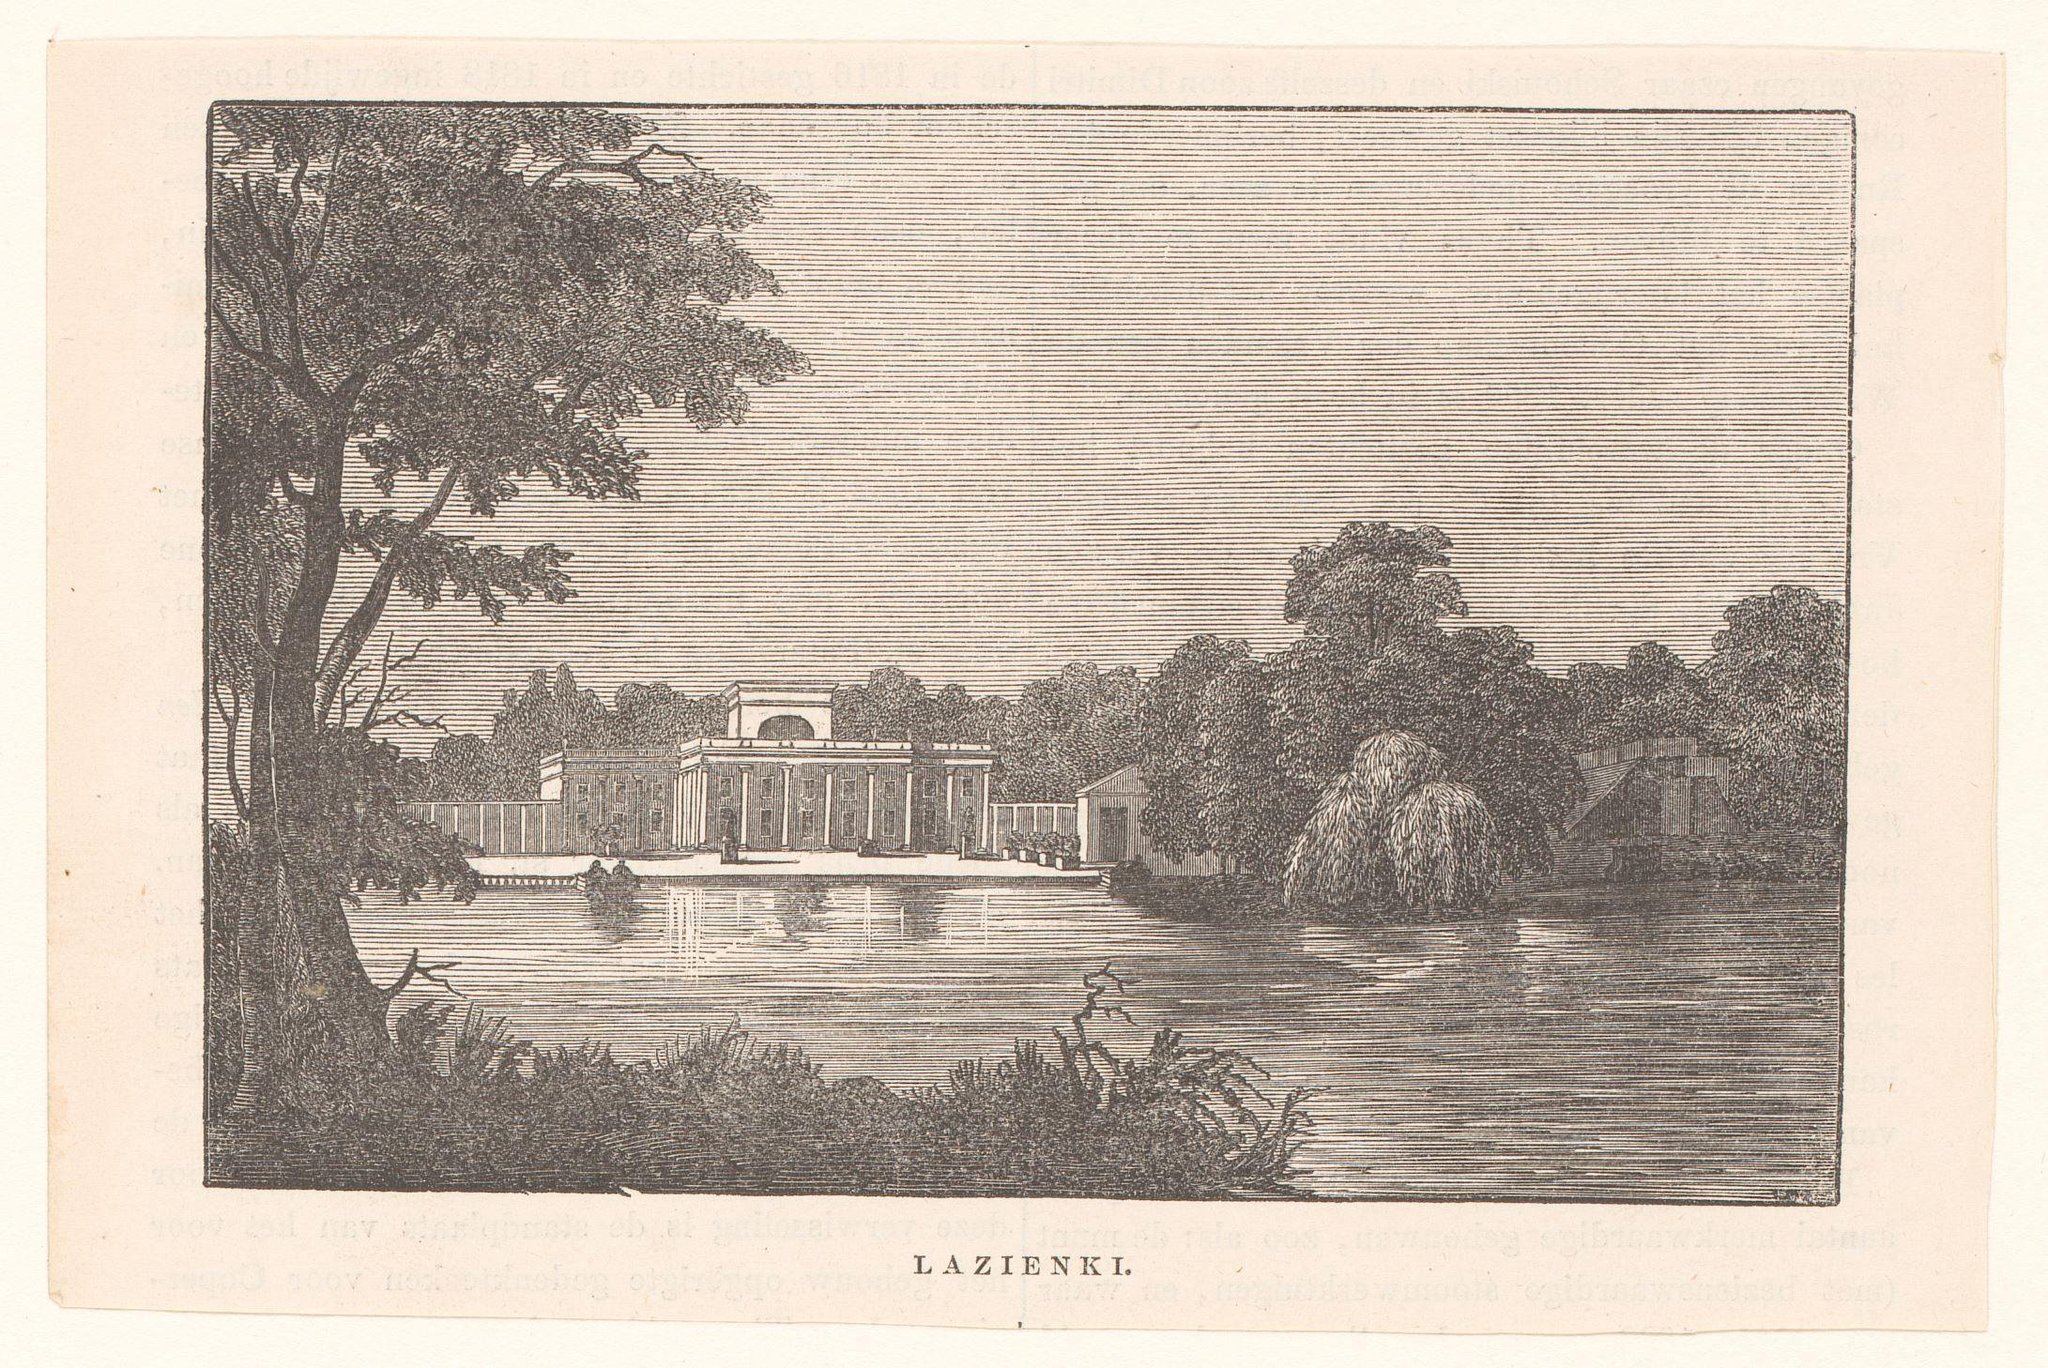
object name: print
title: Lazienki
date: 1847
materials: paper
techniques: letterpress printing, engraving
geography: amsterdam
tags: park, palace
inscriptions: collector's mark: Lugt 2228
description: Prent gebruikt in: Witkamp, P.H. Beschrijving van Oost- en Noord-Europa. Amsterdam: J.H. Laarman, 1847.